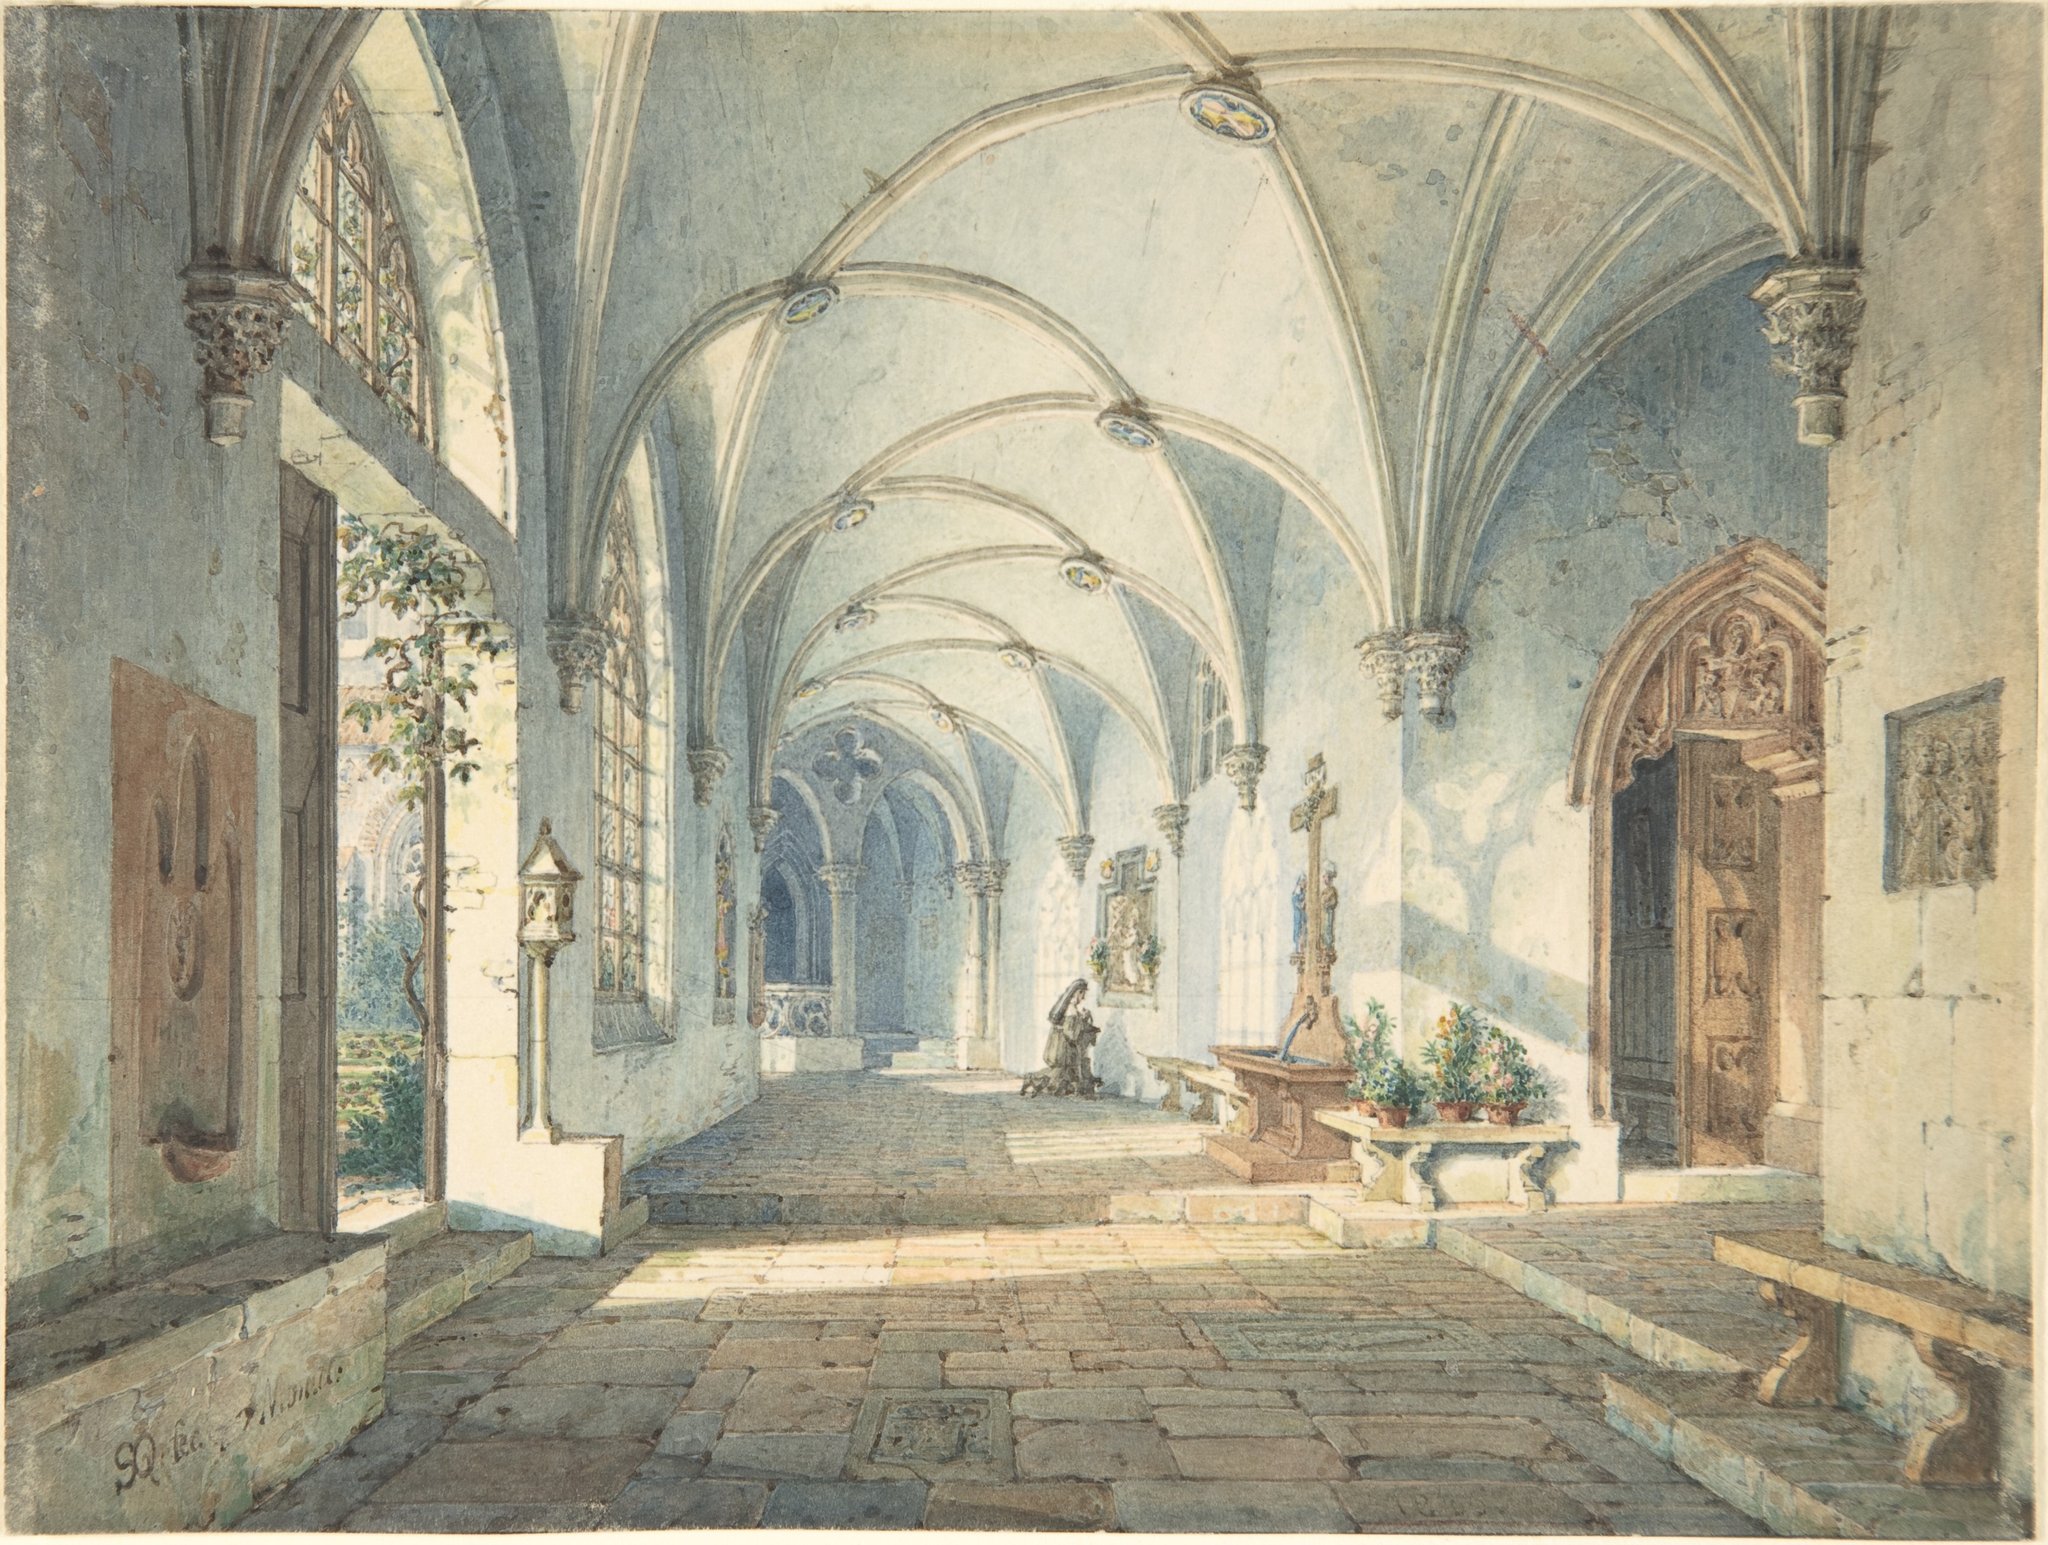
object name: drawing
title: Cloisters in a Nunnery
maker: simon quaglio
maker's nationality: german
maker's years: 1795-1878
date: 1835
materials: watercolor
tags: cloisters